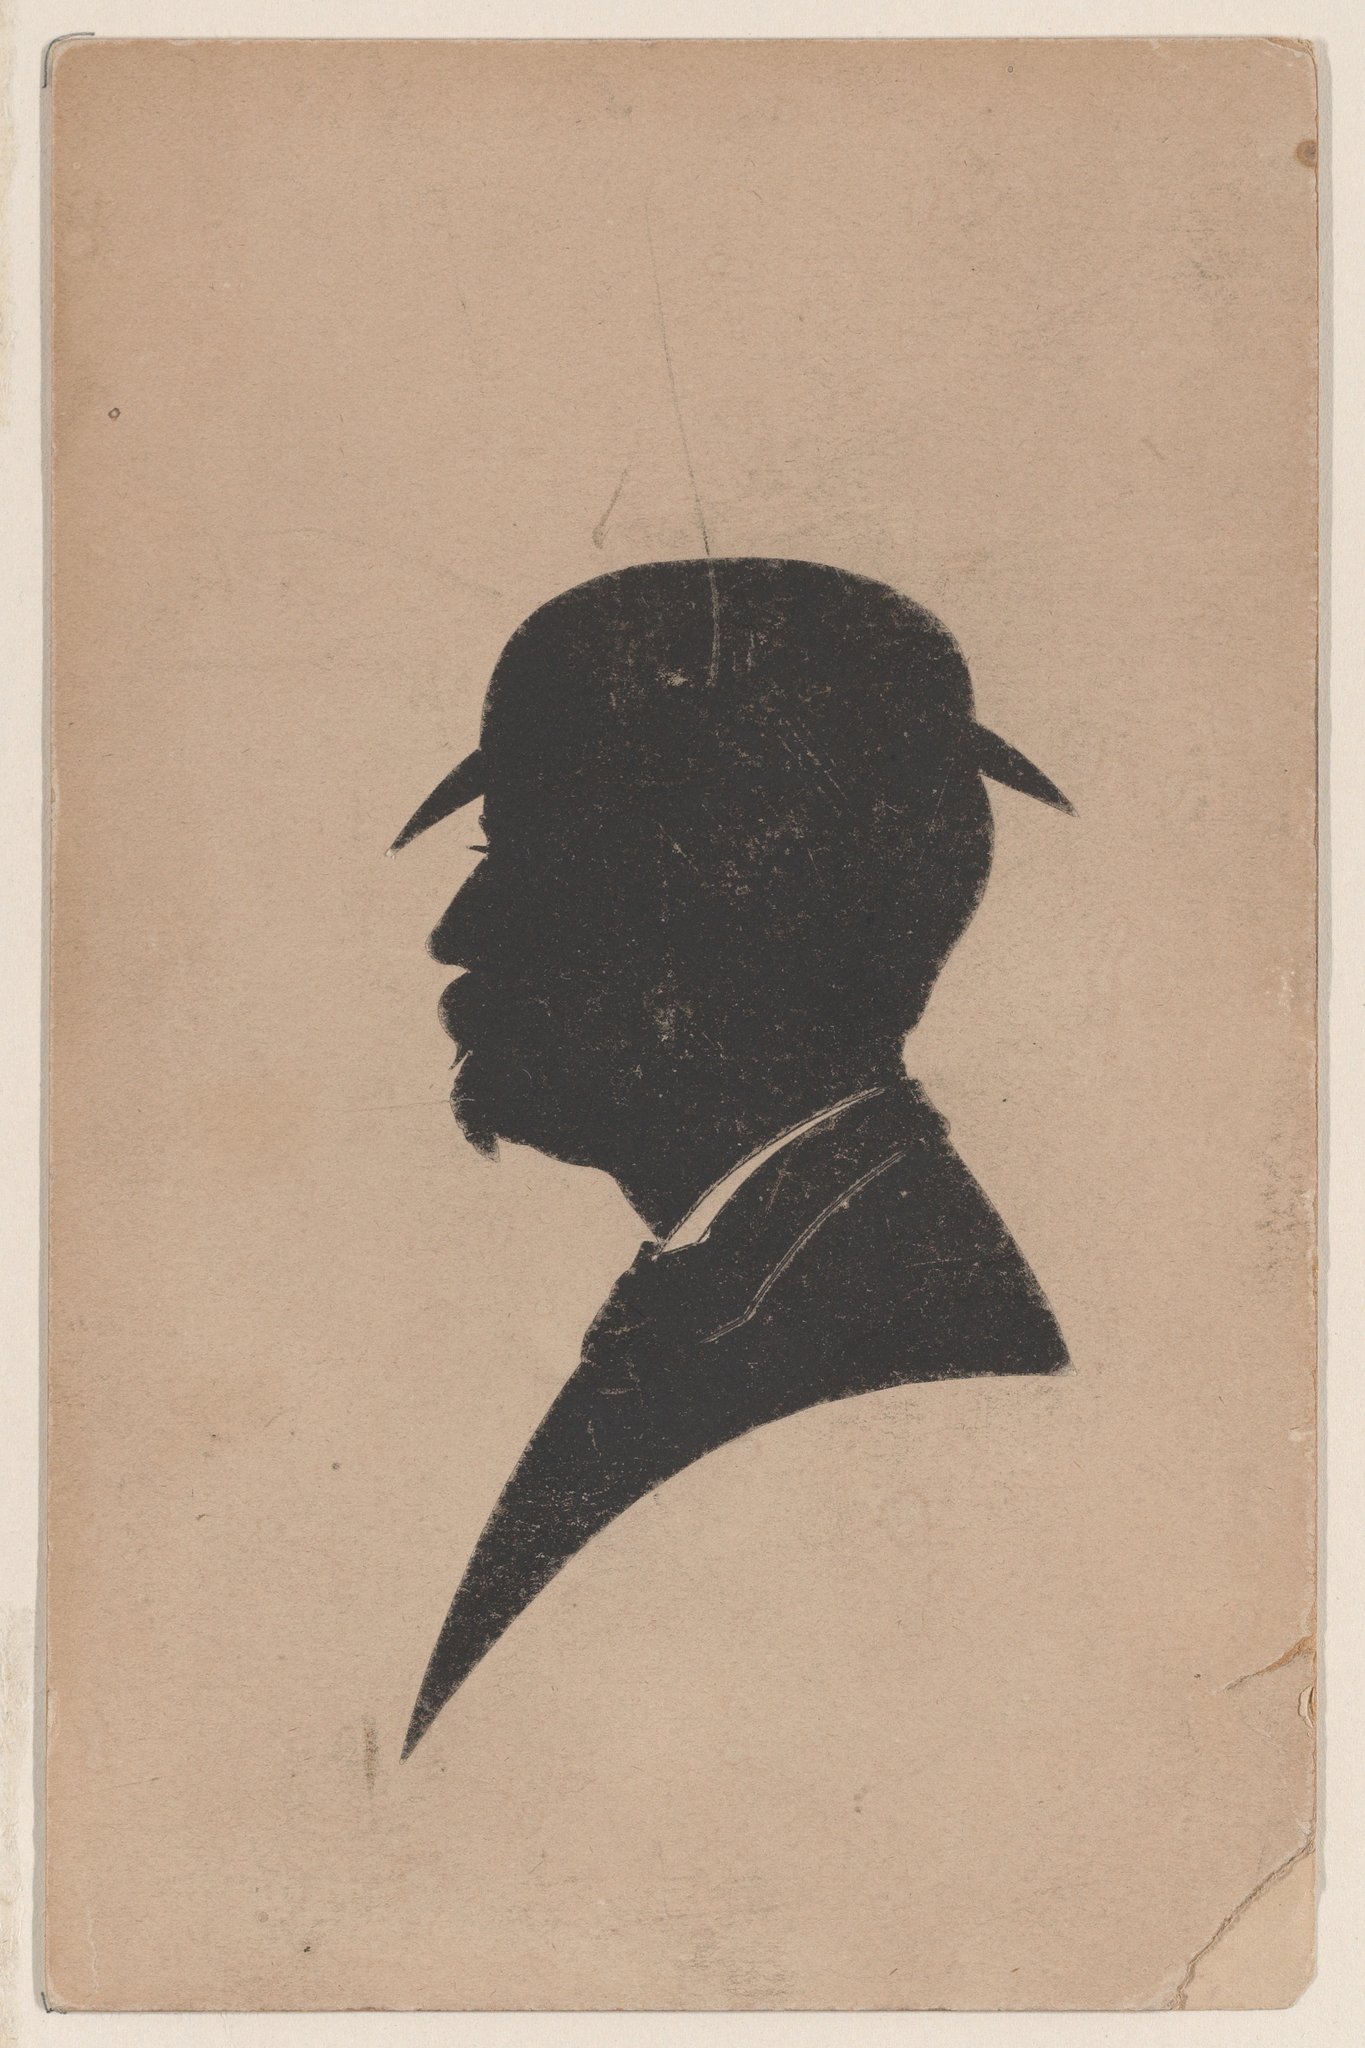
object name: cut paper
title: Silhouette of an unknown man with a derby hat, moustache and goatee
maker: Anonymous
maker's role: artist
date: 1801-1900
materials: paper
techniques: cutting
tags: men